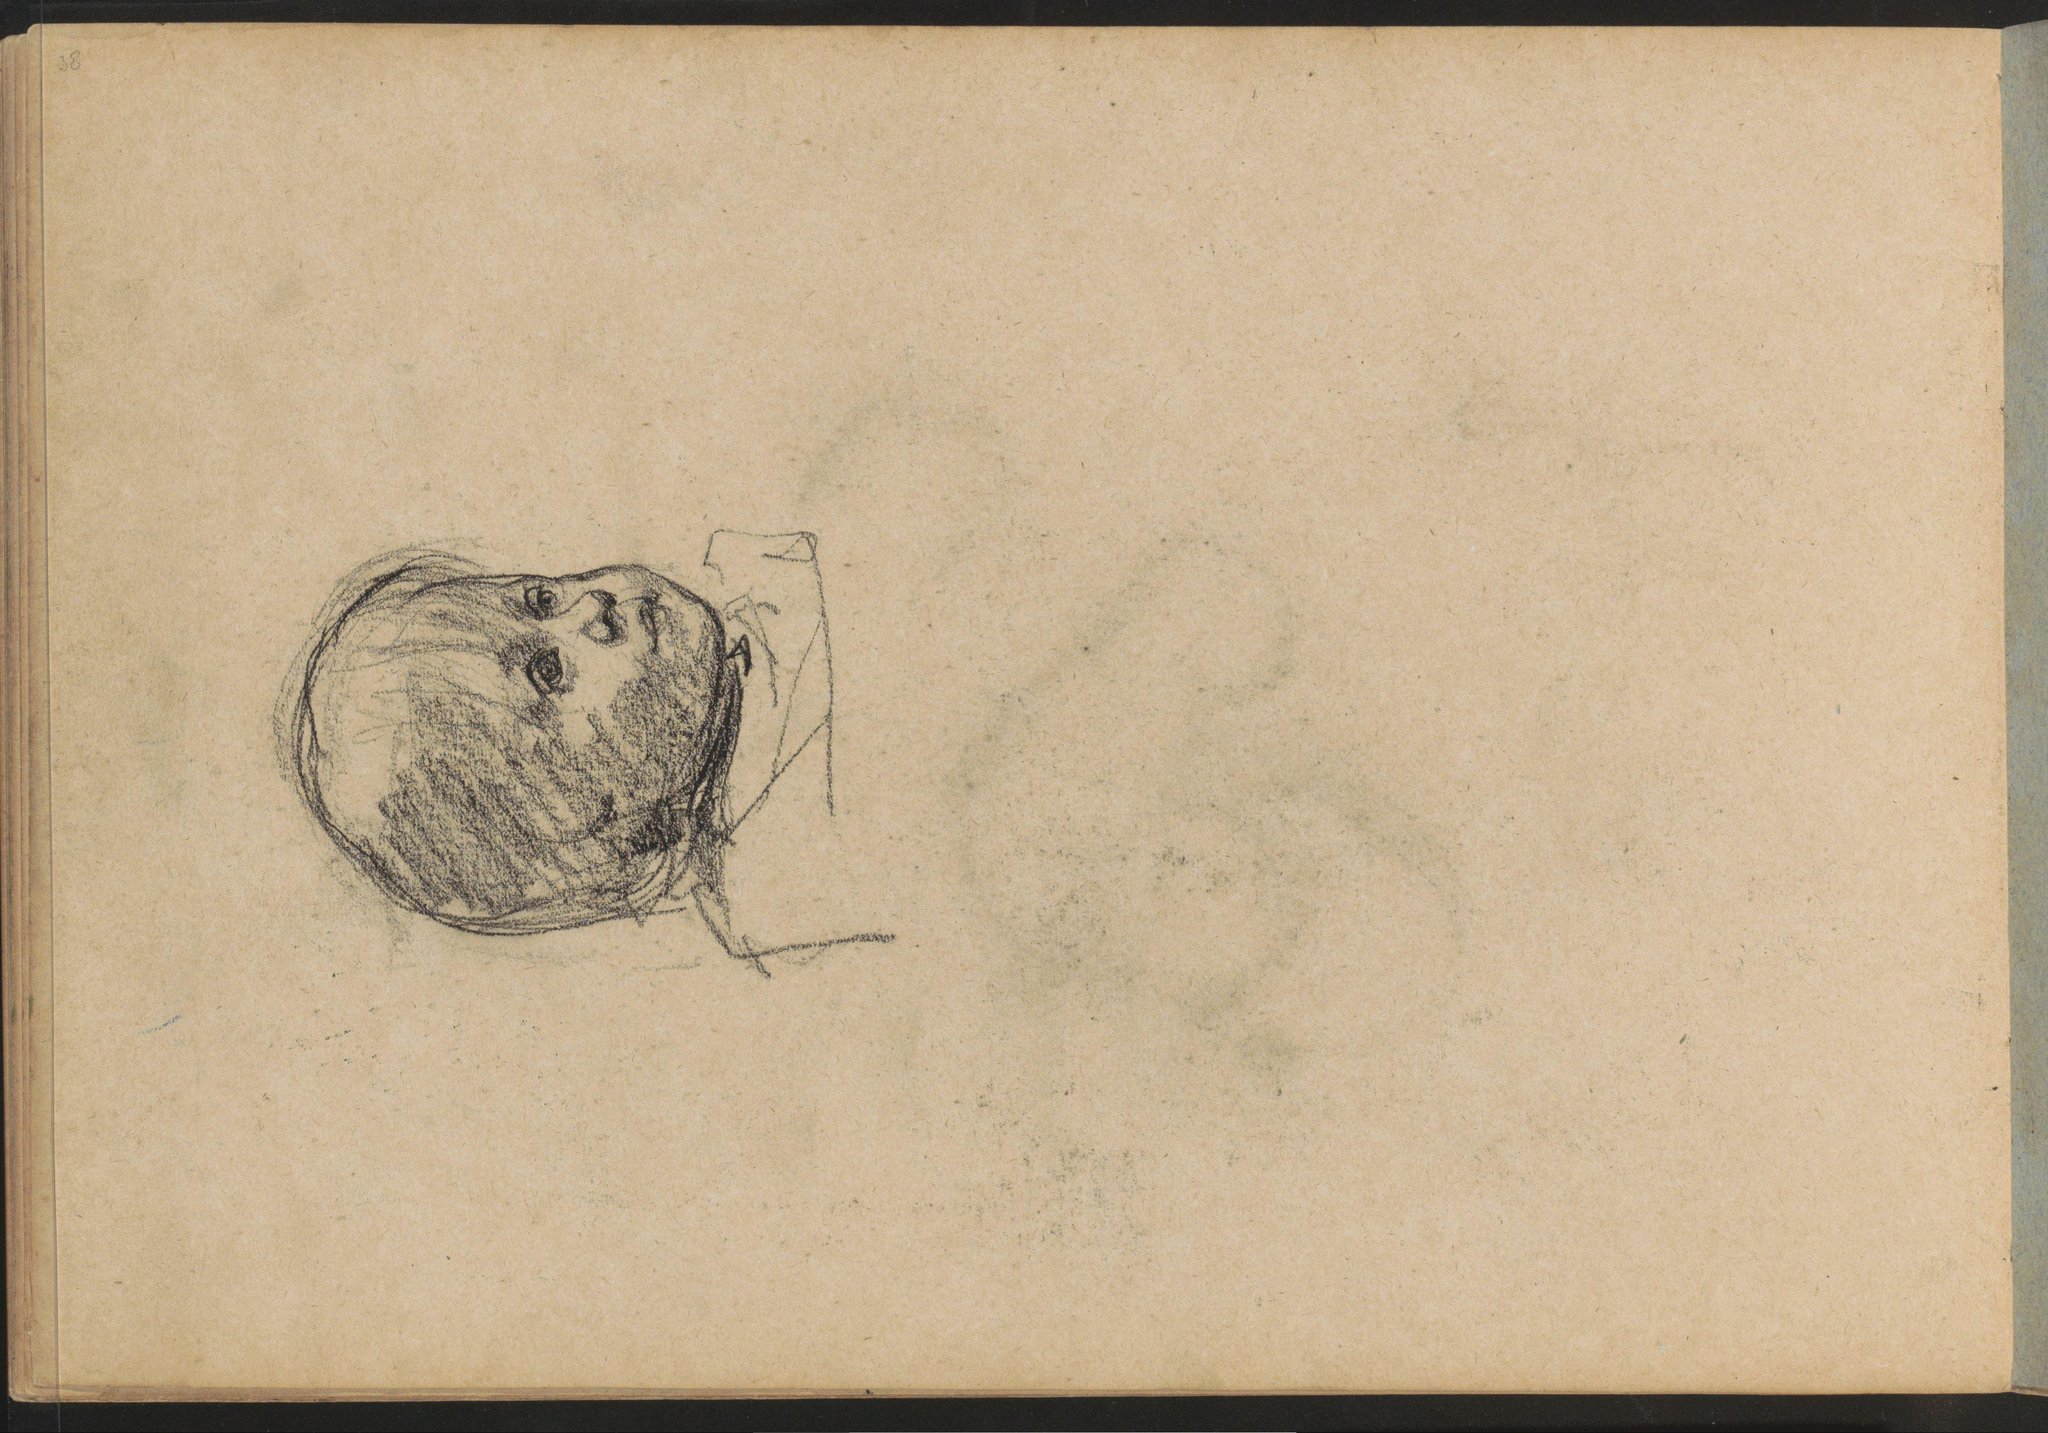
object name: sketchbook leaf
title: Hoofd van een kind, mogelijk een meisje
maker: willem witsen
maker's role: draughtsman, painter, print maker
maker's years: 1860-1923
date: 1884-1887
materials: chalk, paper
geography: ewijkshoeve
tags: head (human), child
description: Pagina 38 uit een schetsboek met 29 bladen.